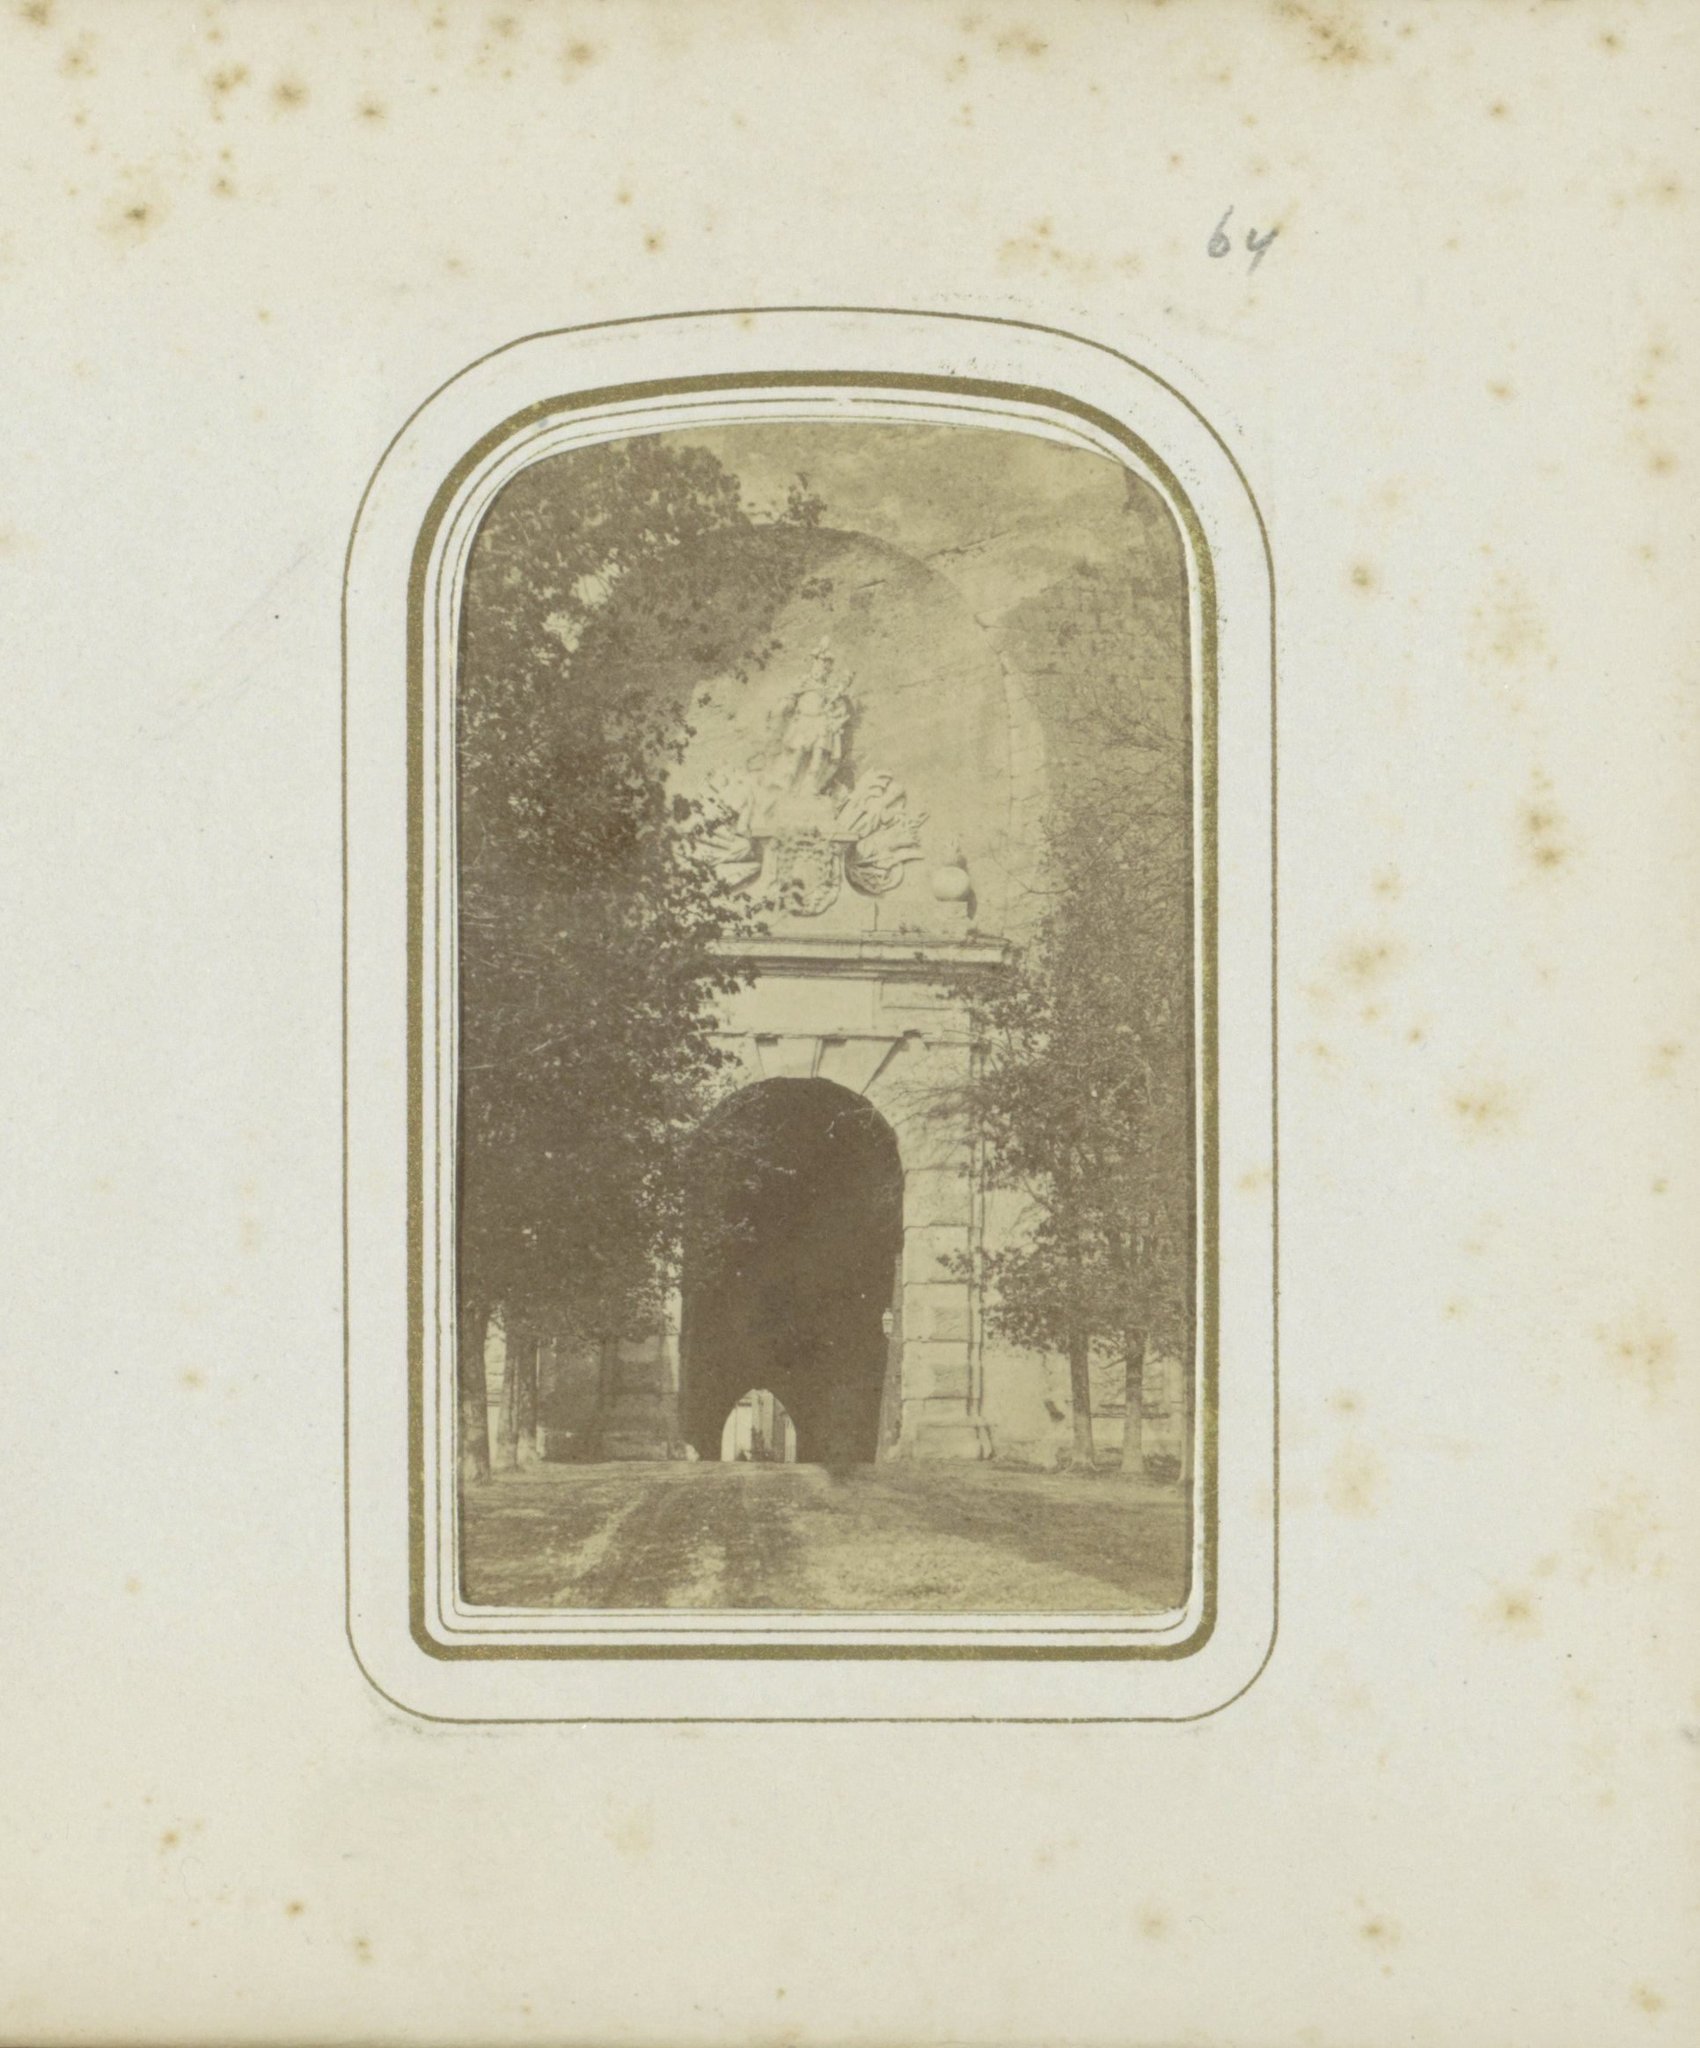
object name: photograph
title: Sigmundstor in de vestingwerken van Salzburg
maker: Anonymous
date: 1865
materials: paper, photographic support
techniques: albumen print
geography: drievuldigheidskerk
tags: gate ~ fortified city, travelling; tourism, underground road, tunnel, permanent fortifications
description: Onderdeel van Fotoalbum van een reis door Zwitserland, Oostenrijk en Duitsland door de Nederlandse familie Derkinderen.